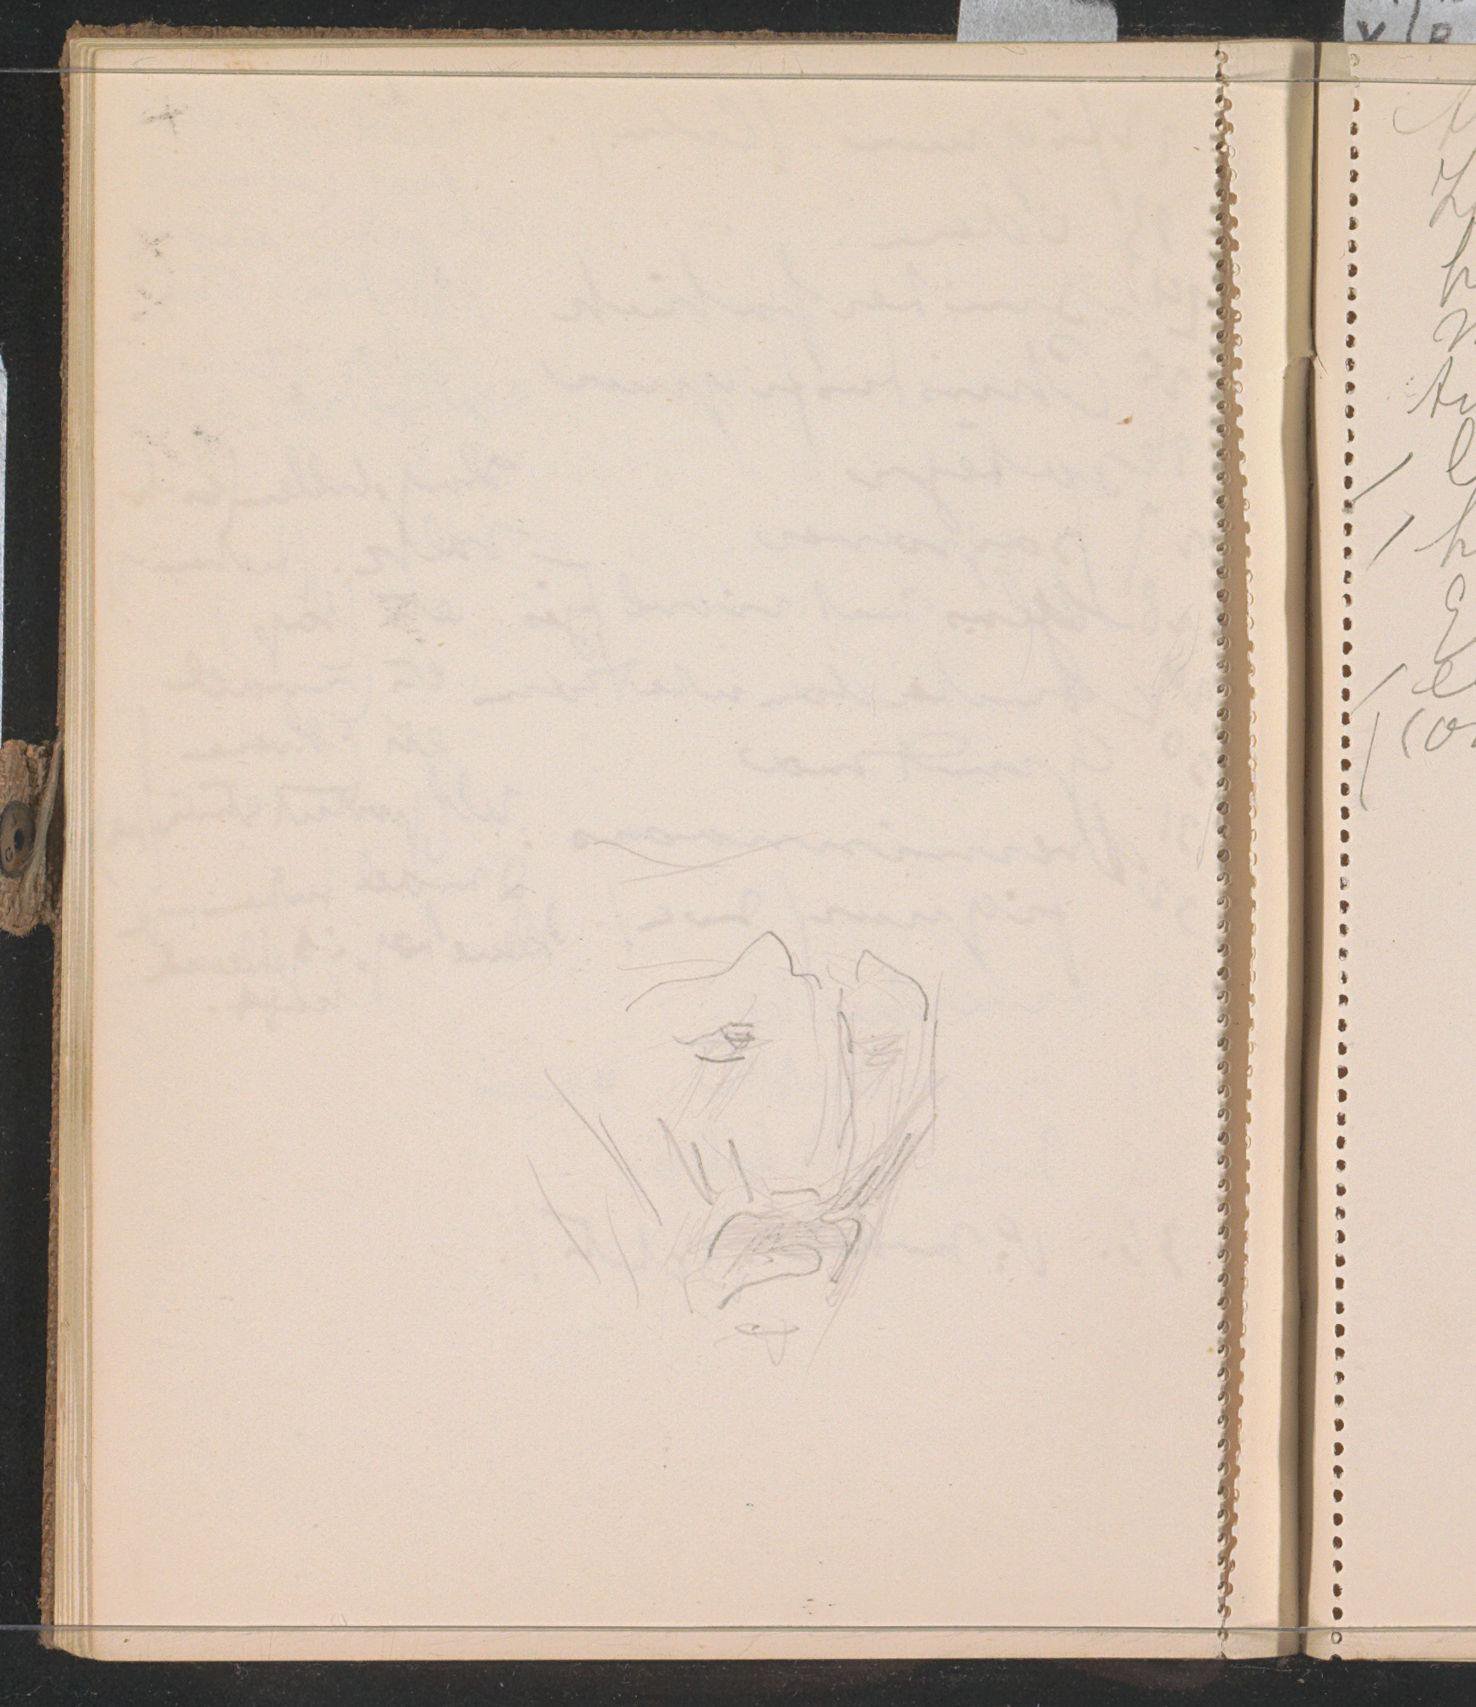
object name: sketchbook leaf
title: Gezicht van een man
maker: reijer stolk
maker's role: draughtsman, print maker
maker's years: 1896-1945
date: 1906-1945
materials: paper, pencil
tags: face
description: Blad 9 verso uit een schetsboek met 42 bladen.